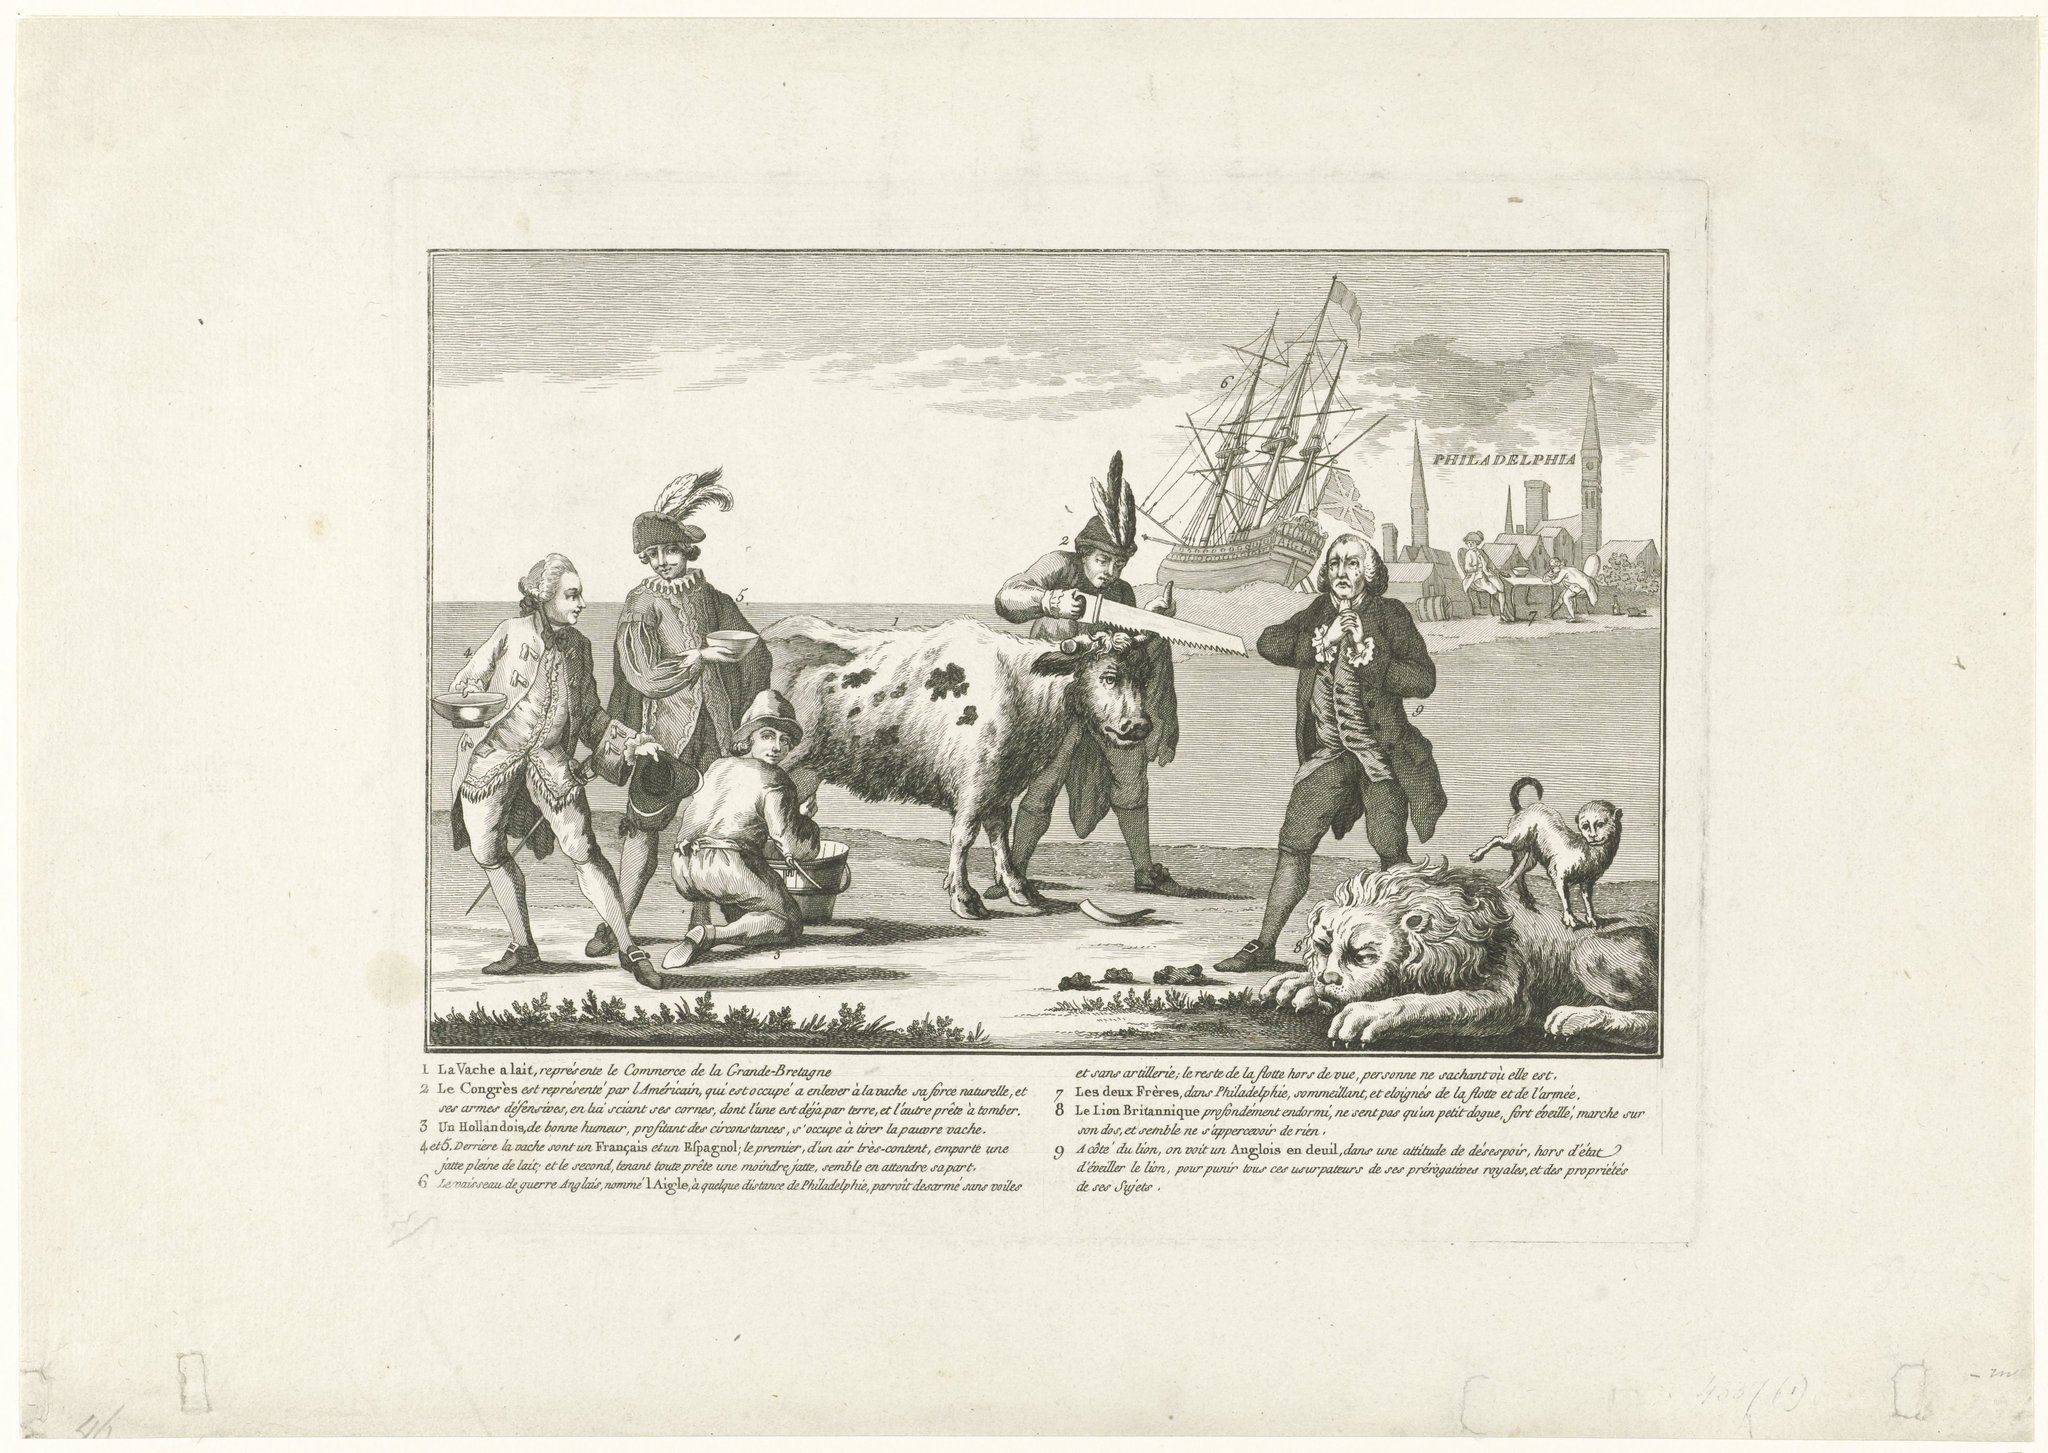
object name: cartoon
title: Spotprent op de Engelse verliezen in de strijd met Amerika (1), 1778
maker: Anonymous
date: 1778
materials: paper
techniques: engraving, etching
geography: northern netherlands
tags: cow, political caricatures and satires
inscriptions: collector's mark: Lugt 2228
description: Eerste spotprent op de Engelse verliezen in de strijd met Amerika in 1778. De Engelse koophandel verbeeld door een melkkoe waarvan het Amerikaanse Congres de horens afzaagt en die door een Hollander wordt gemolken. Een Fransman en een Spanjaard willen ook van het melk hebben. Op de achtergrond het door de Amerikanen veroverde en onttakelde Engelse schip de Eagle (17 september 1778) gestrand nabij Philadelphia. Op de voorgrond pist een hondje op de slapende Britse leeuw, hierbij een handenwringende Engelsman in rouwgewaad. In het onderschrift de legenda 1-9 in het Frans.